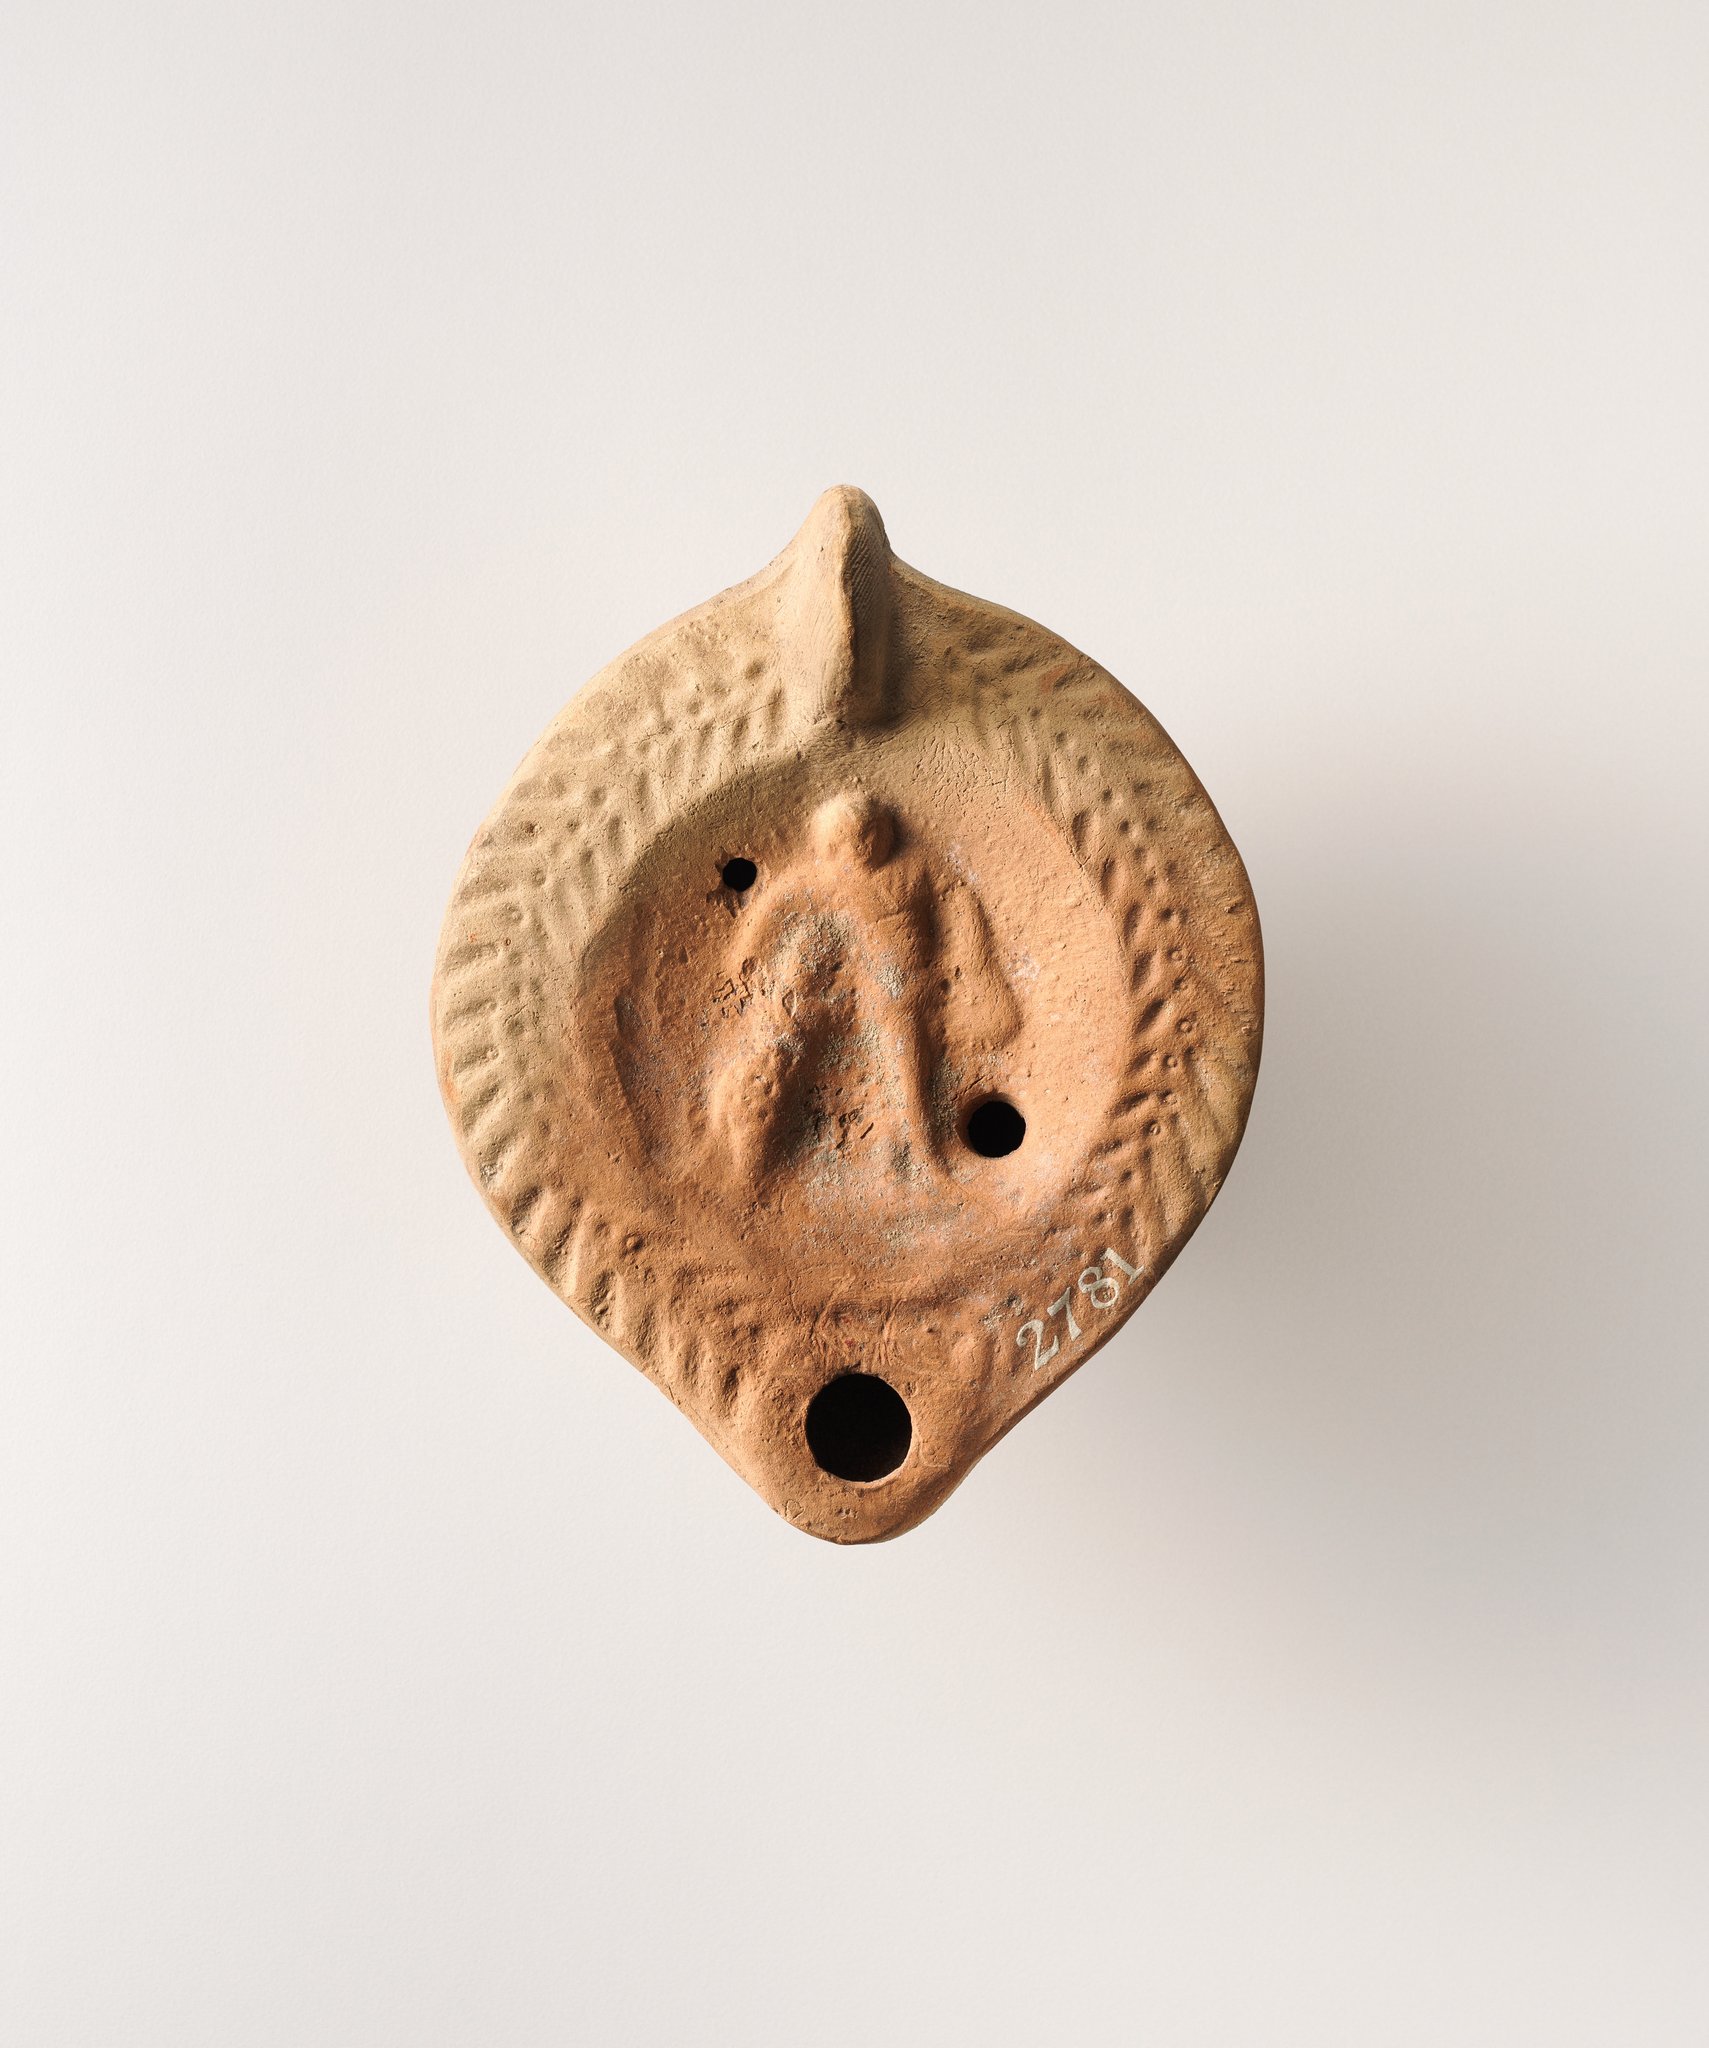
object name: lamp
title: Terracotta oil lamp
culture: roman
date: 101-200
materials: terracotta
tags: men